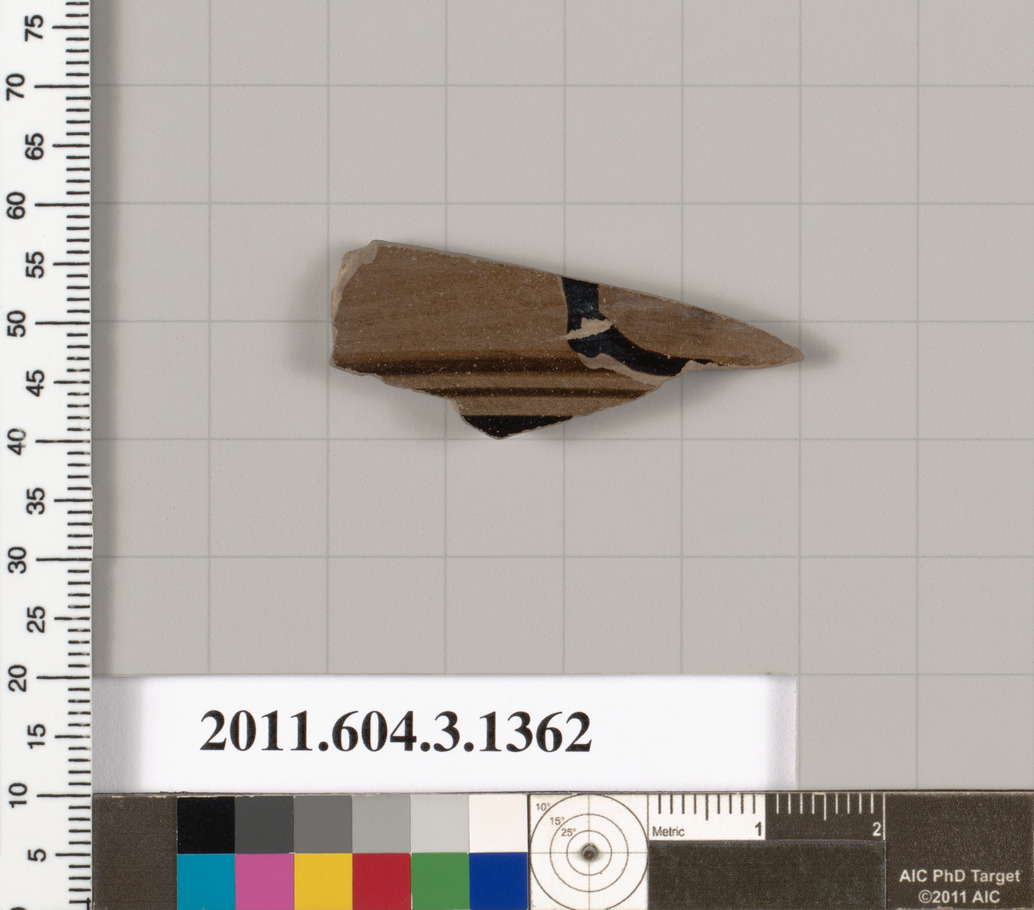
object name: skyphos fragment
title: Terracotta fragment of a skyphos (deep drinking cup)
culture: greek, attic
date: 500-468 BCE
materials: terracotta